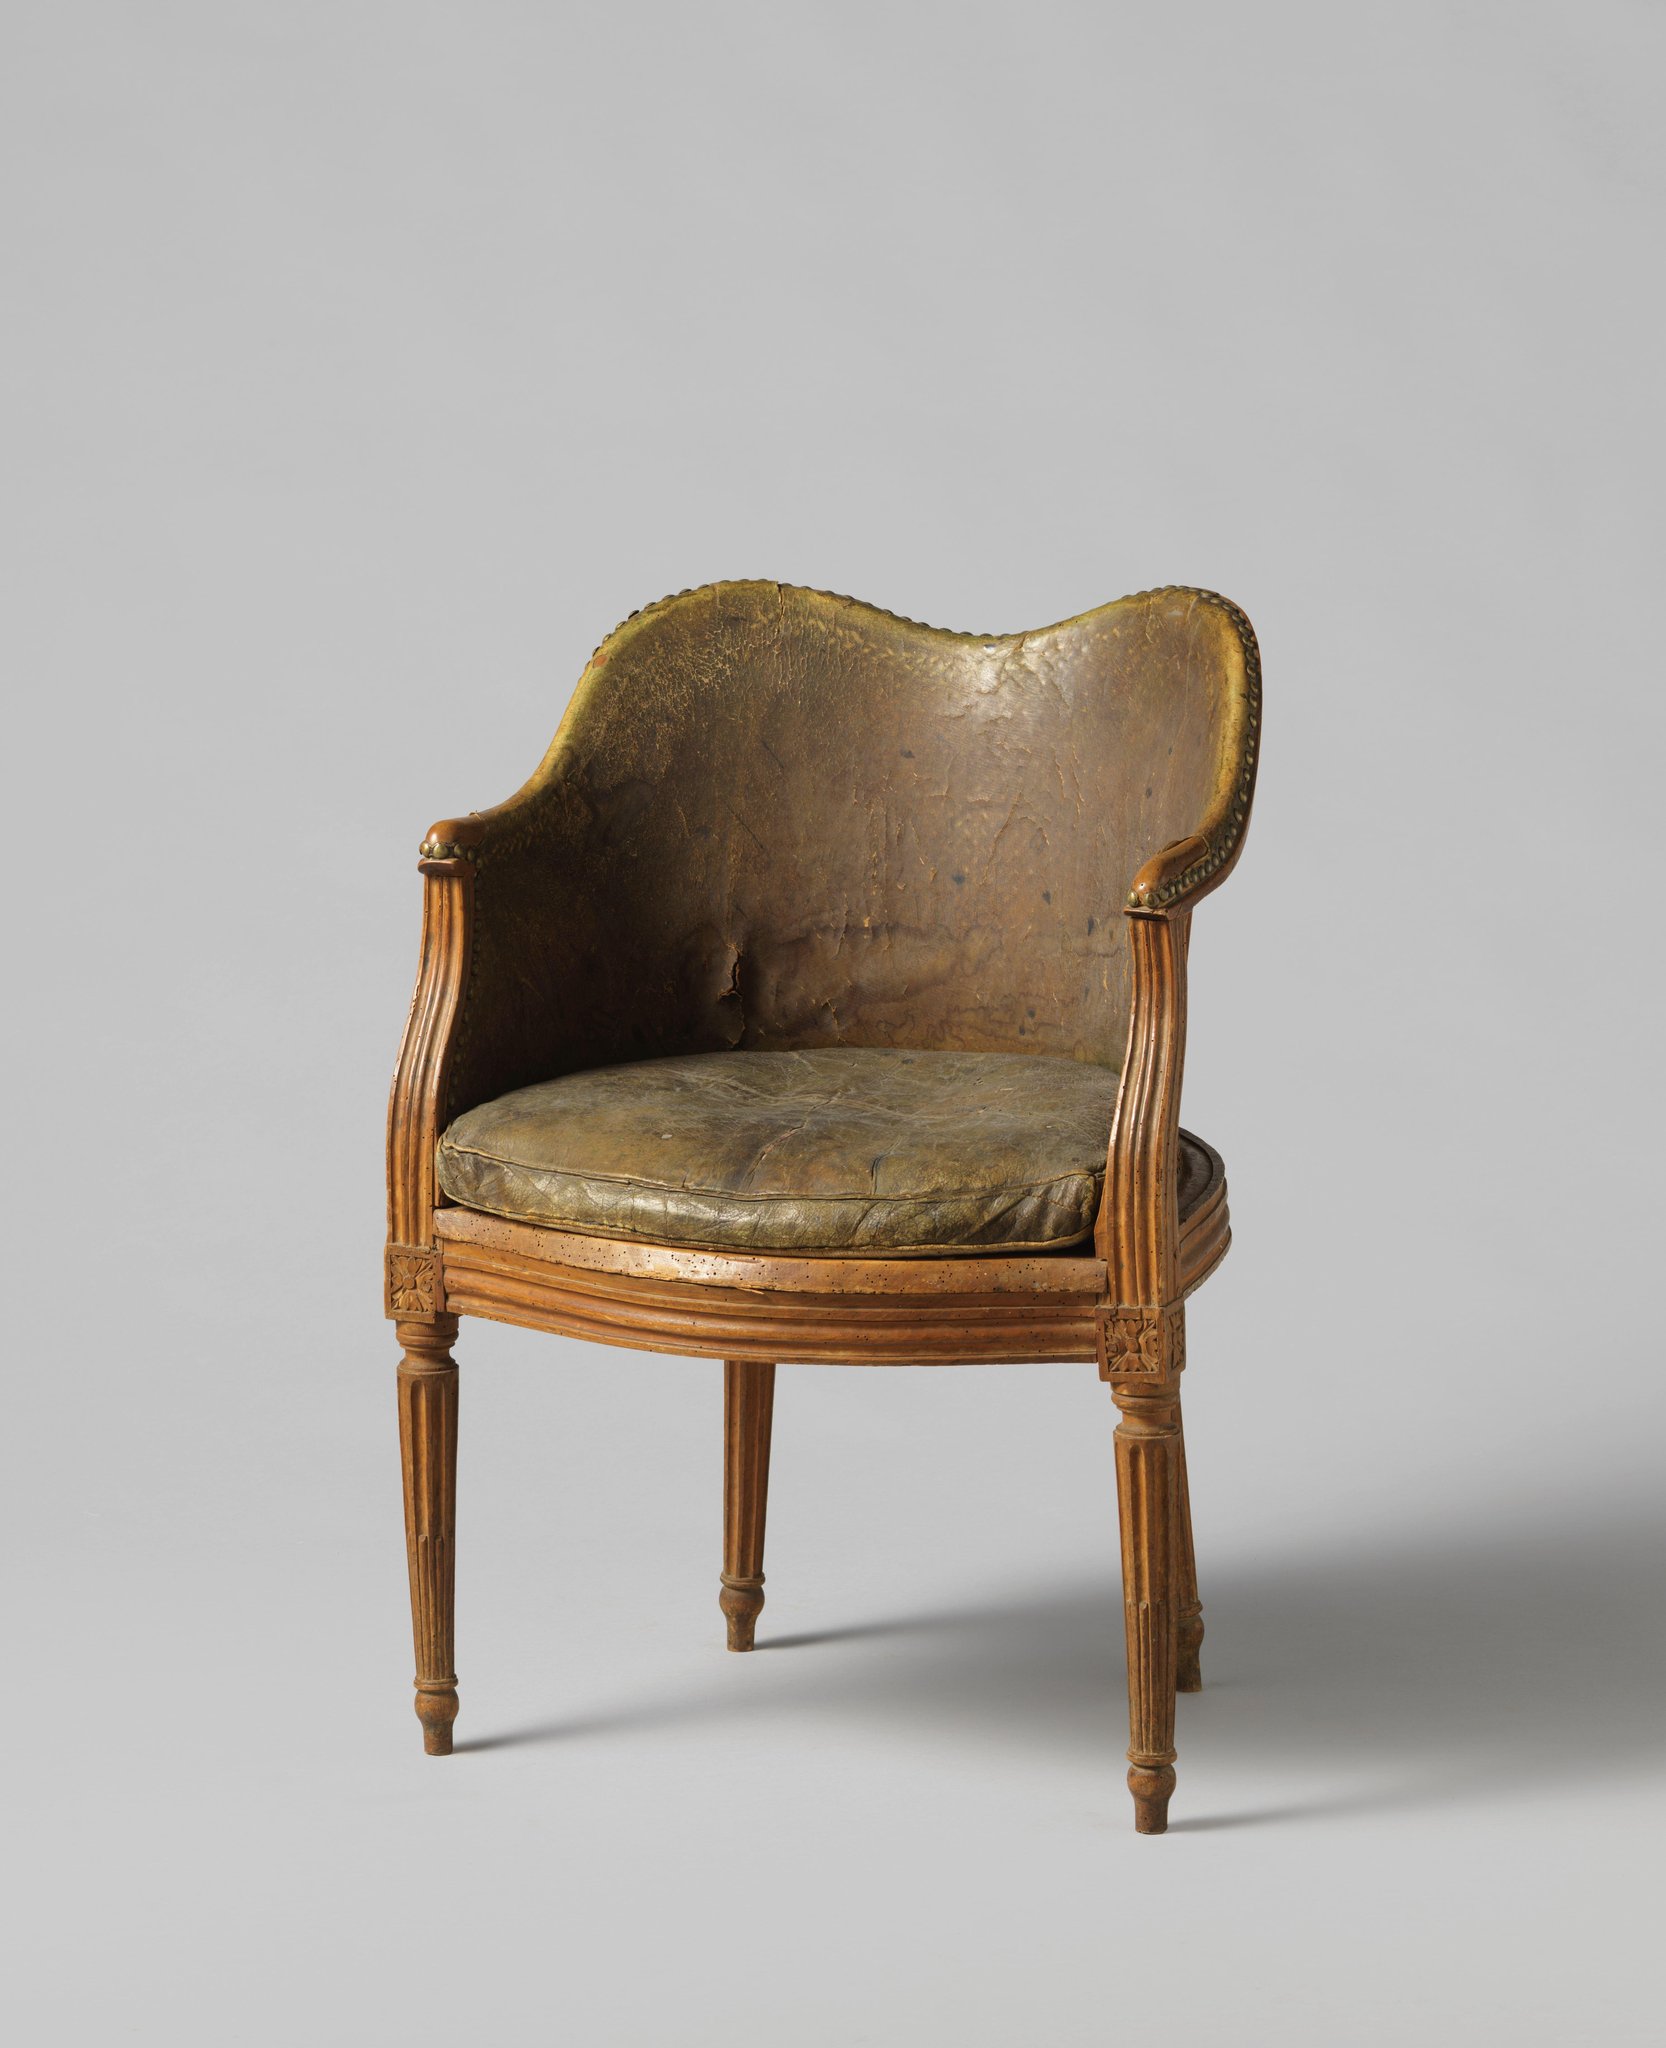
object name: chair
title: Armstoel van beukenhout met vier gecanneleerde poten, halfcirkelvormig zitraam en S-vormig gebogen gecanneleerde armstutten, rug en zitting van riet, met los kussen van leer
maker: Anonymous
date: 1785-1800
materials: wood, leather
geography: france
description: Armstoel van beukenhout, rustend op vier conische gecanneleerde poten. Het zitraam is halfcirkelvormig en heeft geprofileerde regels. De gestrekt S-vormige armstutten zijn gecanneleerd. Het geholde rugraam is aan de bovenzijde ingebogen. De rug en zitting zijn met modern riet bekleed; de rug heeft rondom een genageld leren bekleding en de zitting heeft een los leren kussen.